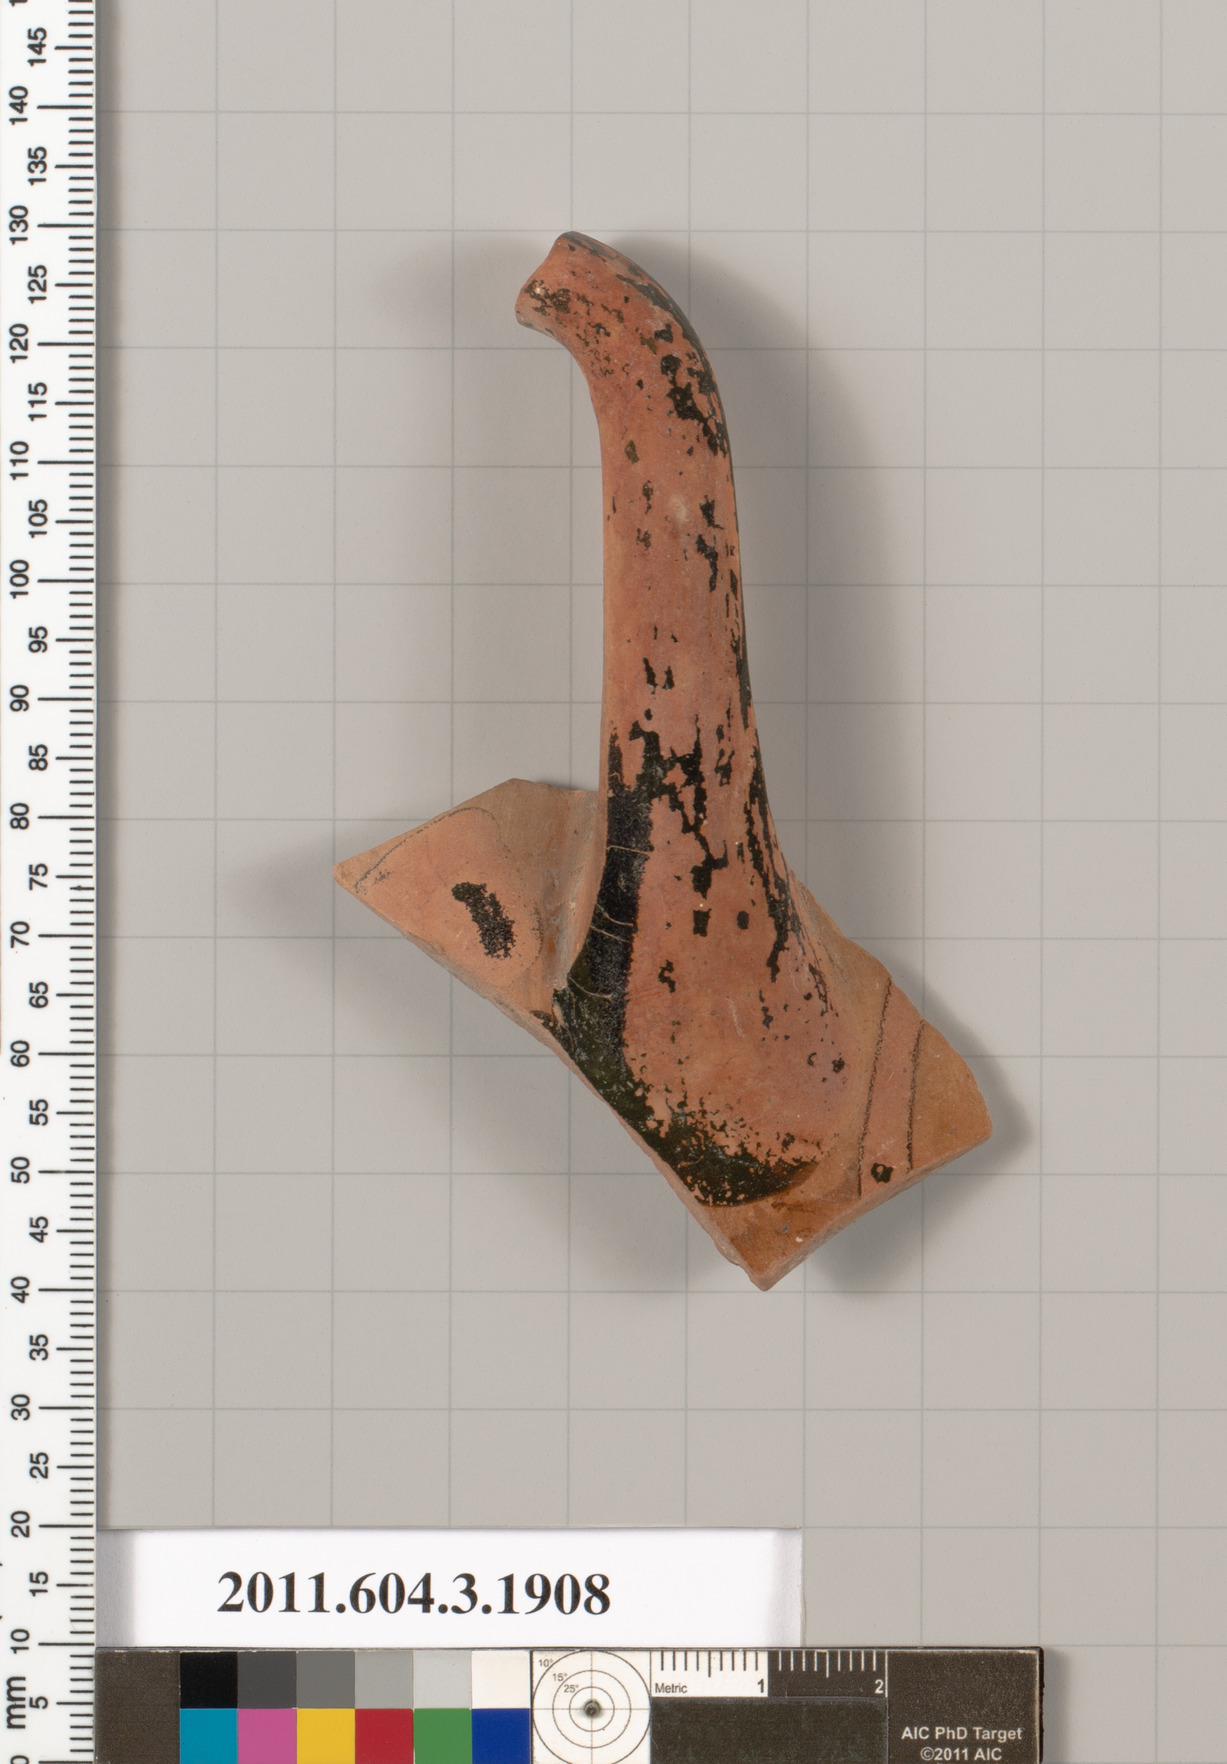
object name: kylix fragment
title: Terracotta fragment of a kylix (drinking cup)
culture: greek, attic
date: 600-401 BCE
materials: terracotta